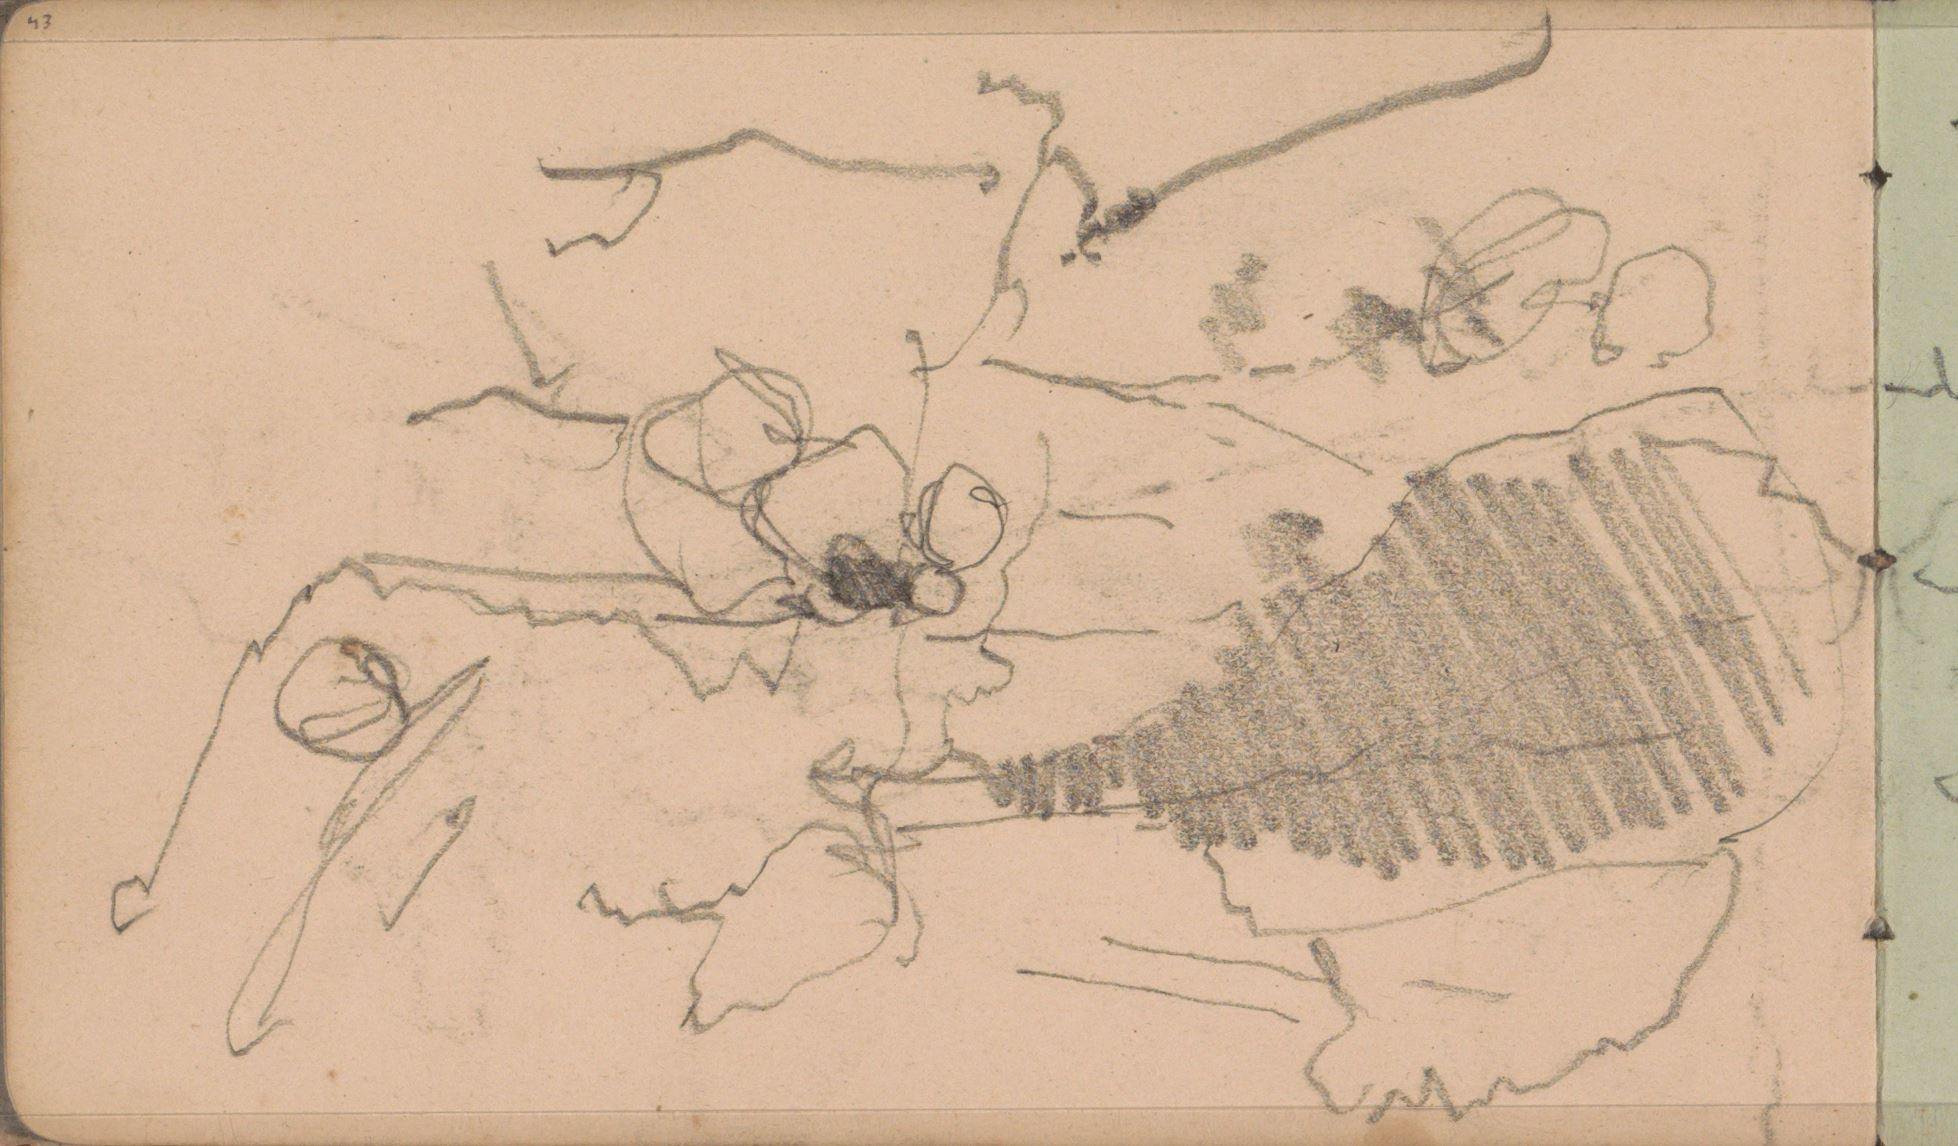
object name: sketchbook leaf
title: Vrouw in een landschap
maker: george hendrik breitner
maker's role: draughtsman, painter, print maker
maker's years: 1857-1923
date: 1881-1883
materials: paper, pencil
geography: north brabant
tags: adult woman, landscapes, mother and baby or young child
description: Op haar arm mogelijk een kind. Pagina 43 uit een schetsboek met 42 bladen.